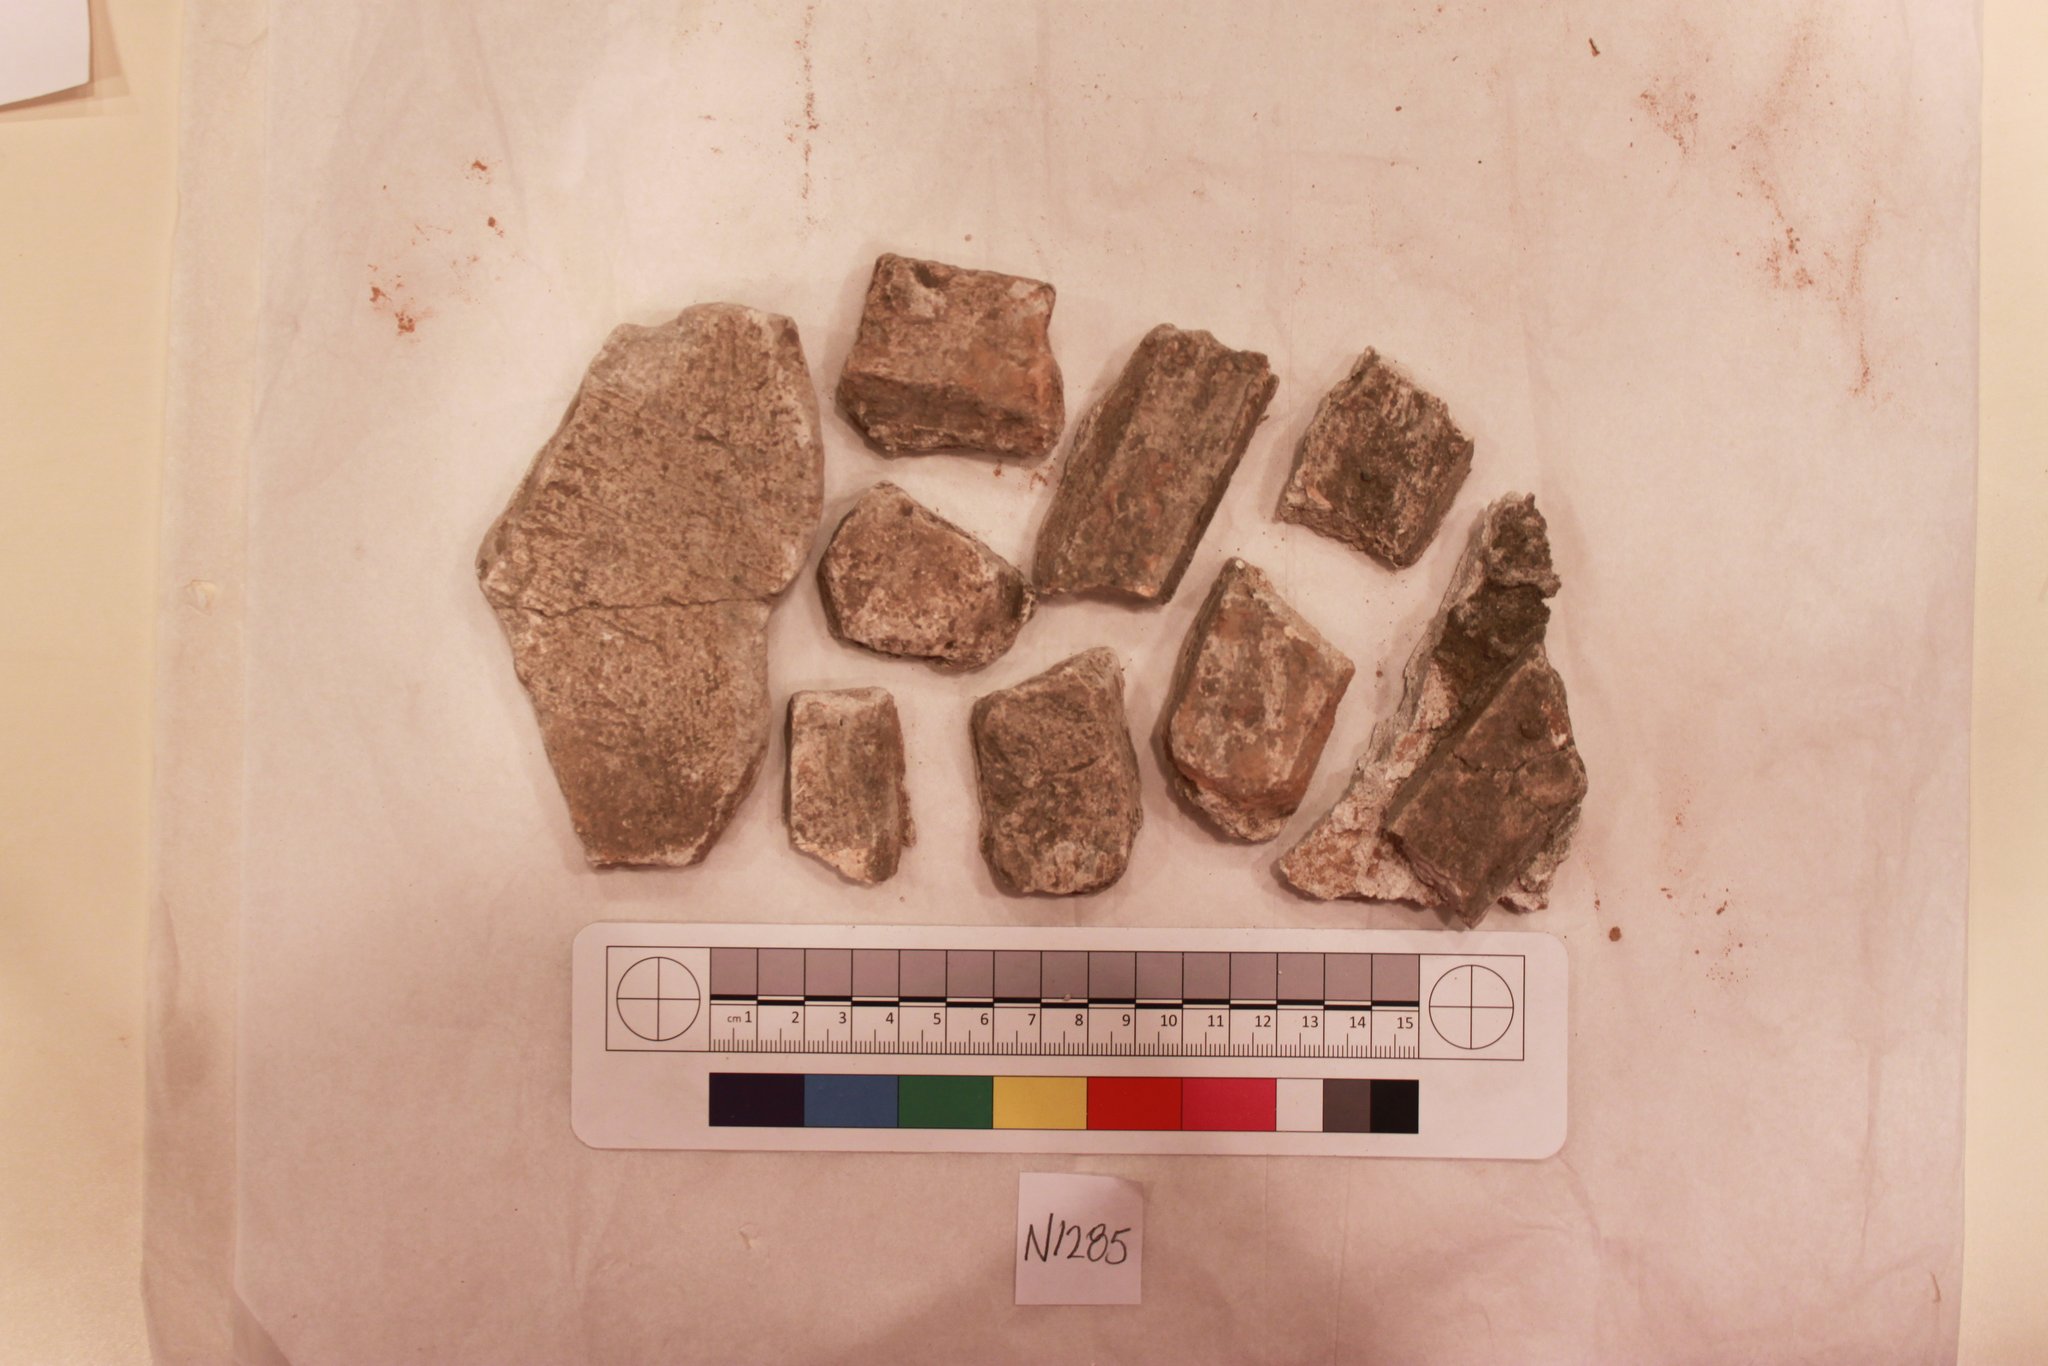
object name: fragment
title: Stucco Fragment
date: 701-1200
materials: plaster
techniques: carving, painting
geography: iran